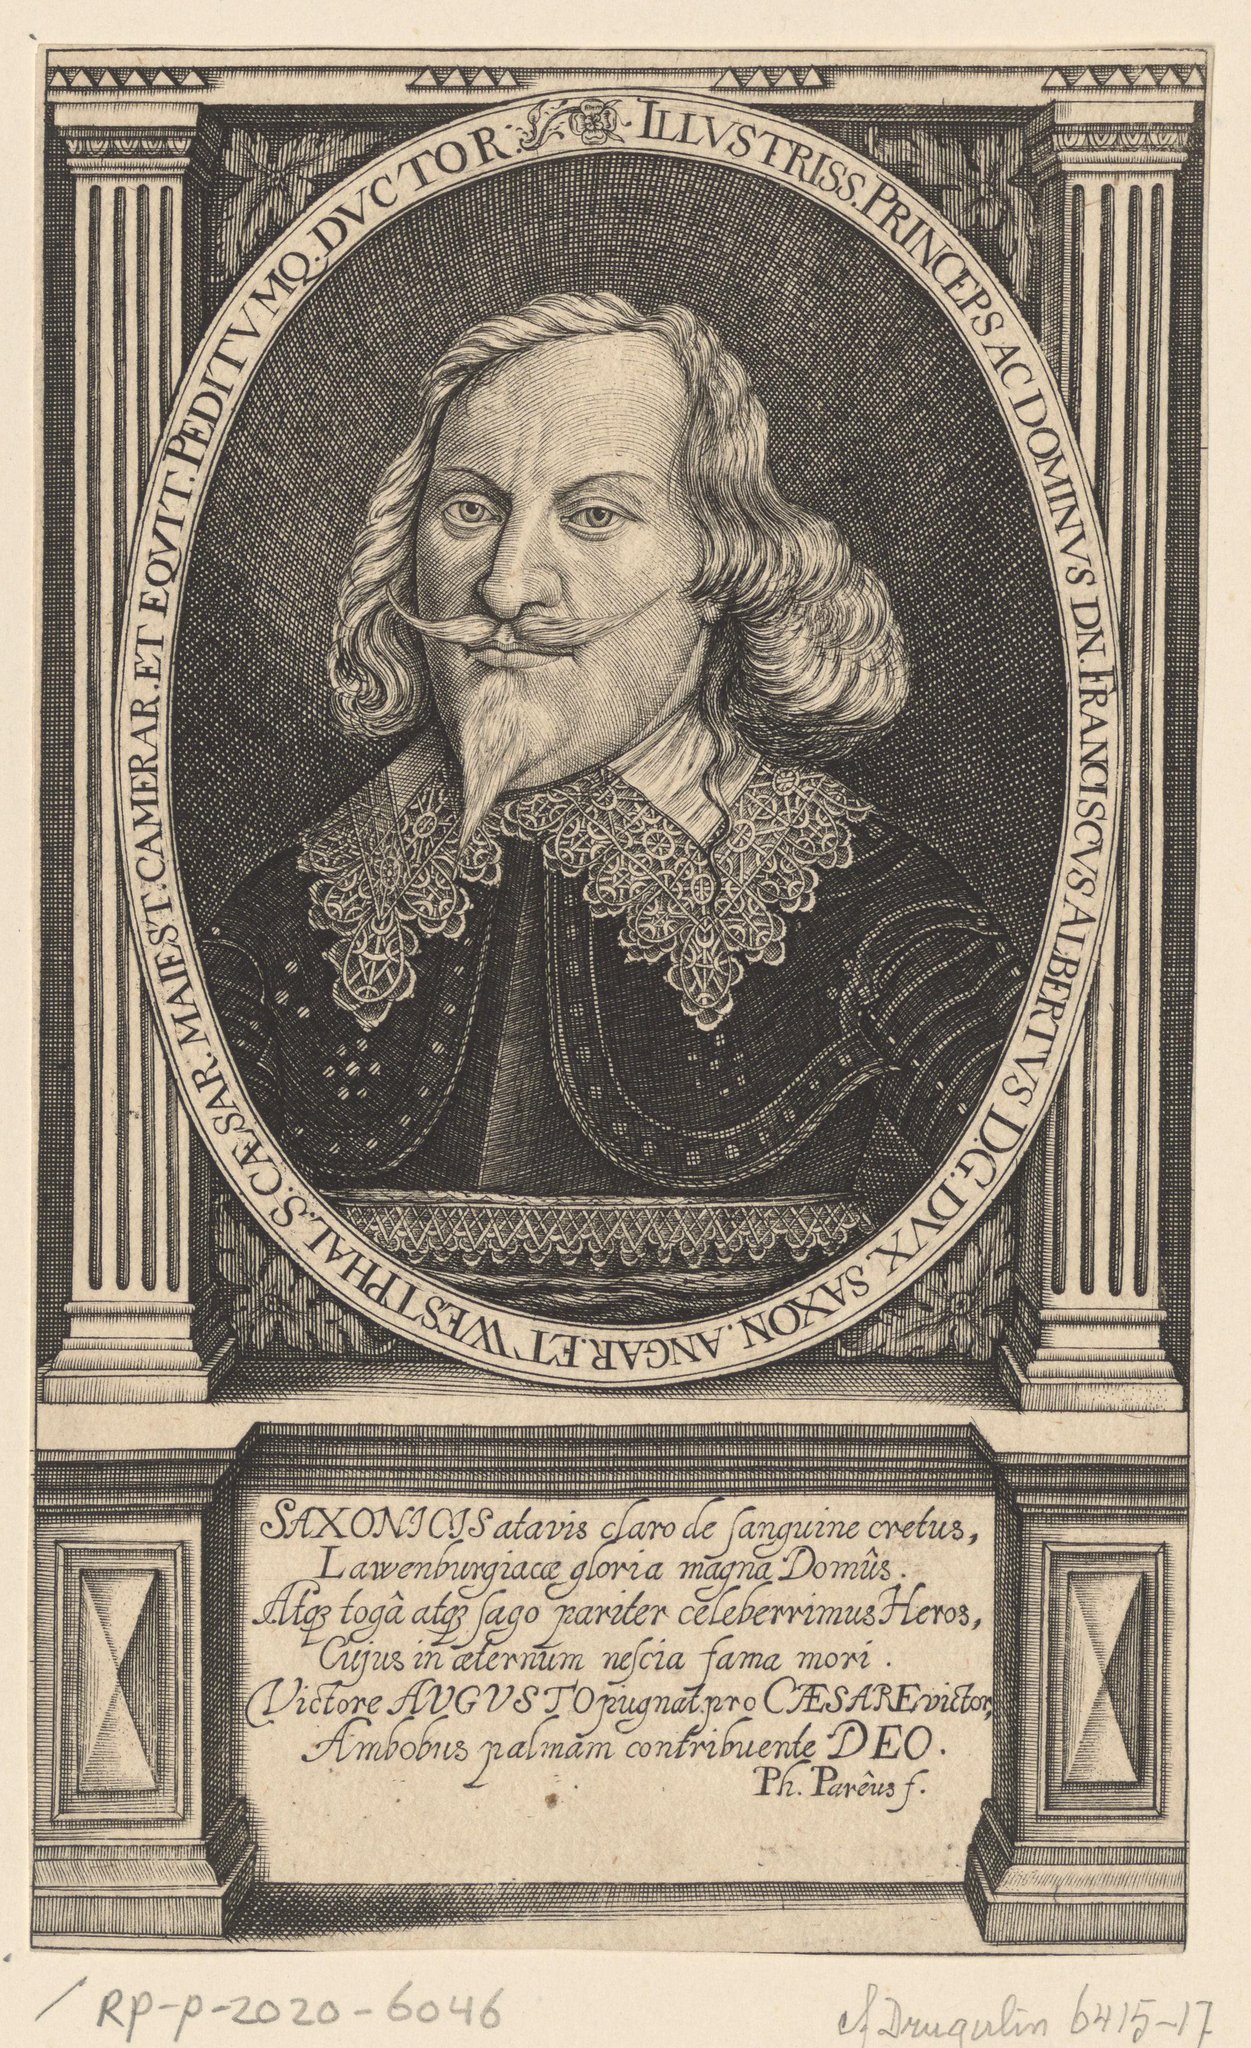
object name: print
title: Portret van Frans Albert hertog van Saksen-Lauenburg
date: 1630-1650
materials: paper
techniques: engraving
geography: germany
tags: ornament ~ medallion, armour, historical persons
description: Met zesregelig vers in het Latijn onder het portret.